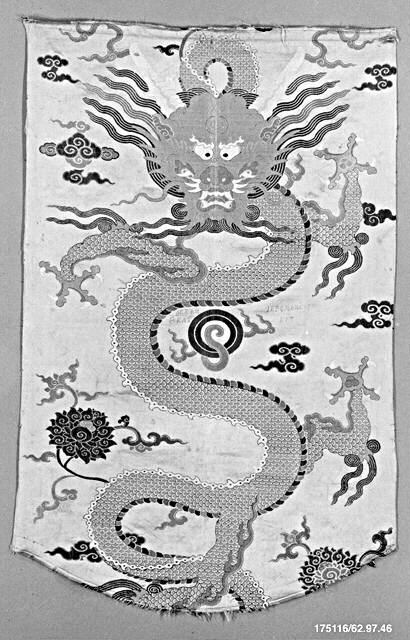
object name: panel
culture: chinese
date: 1601-1700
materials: silk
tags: dragons,flowers